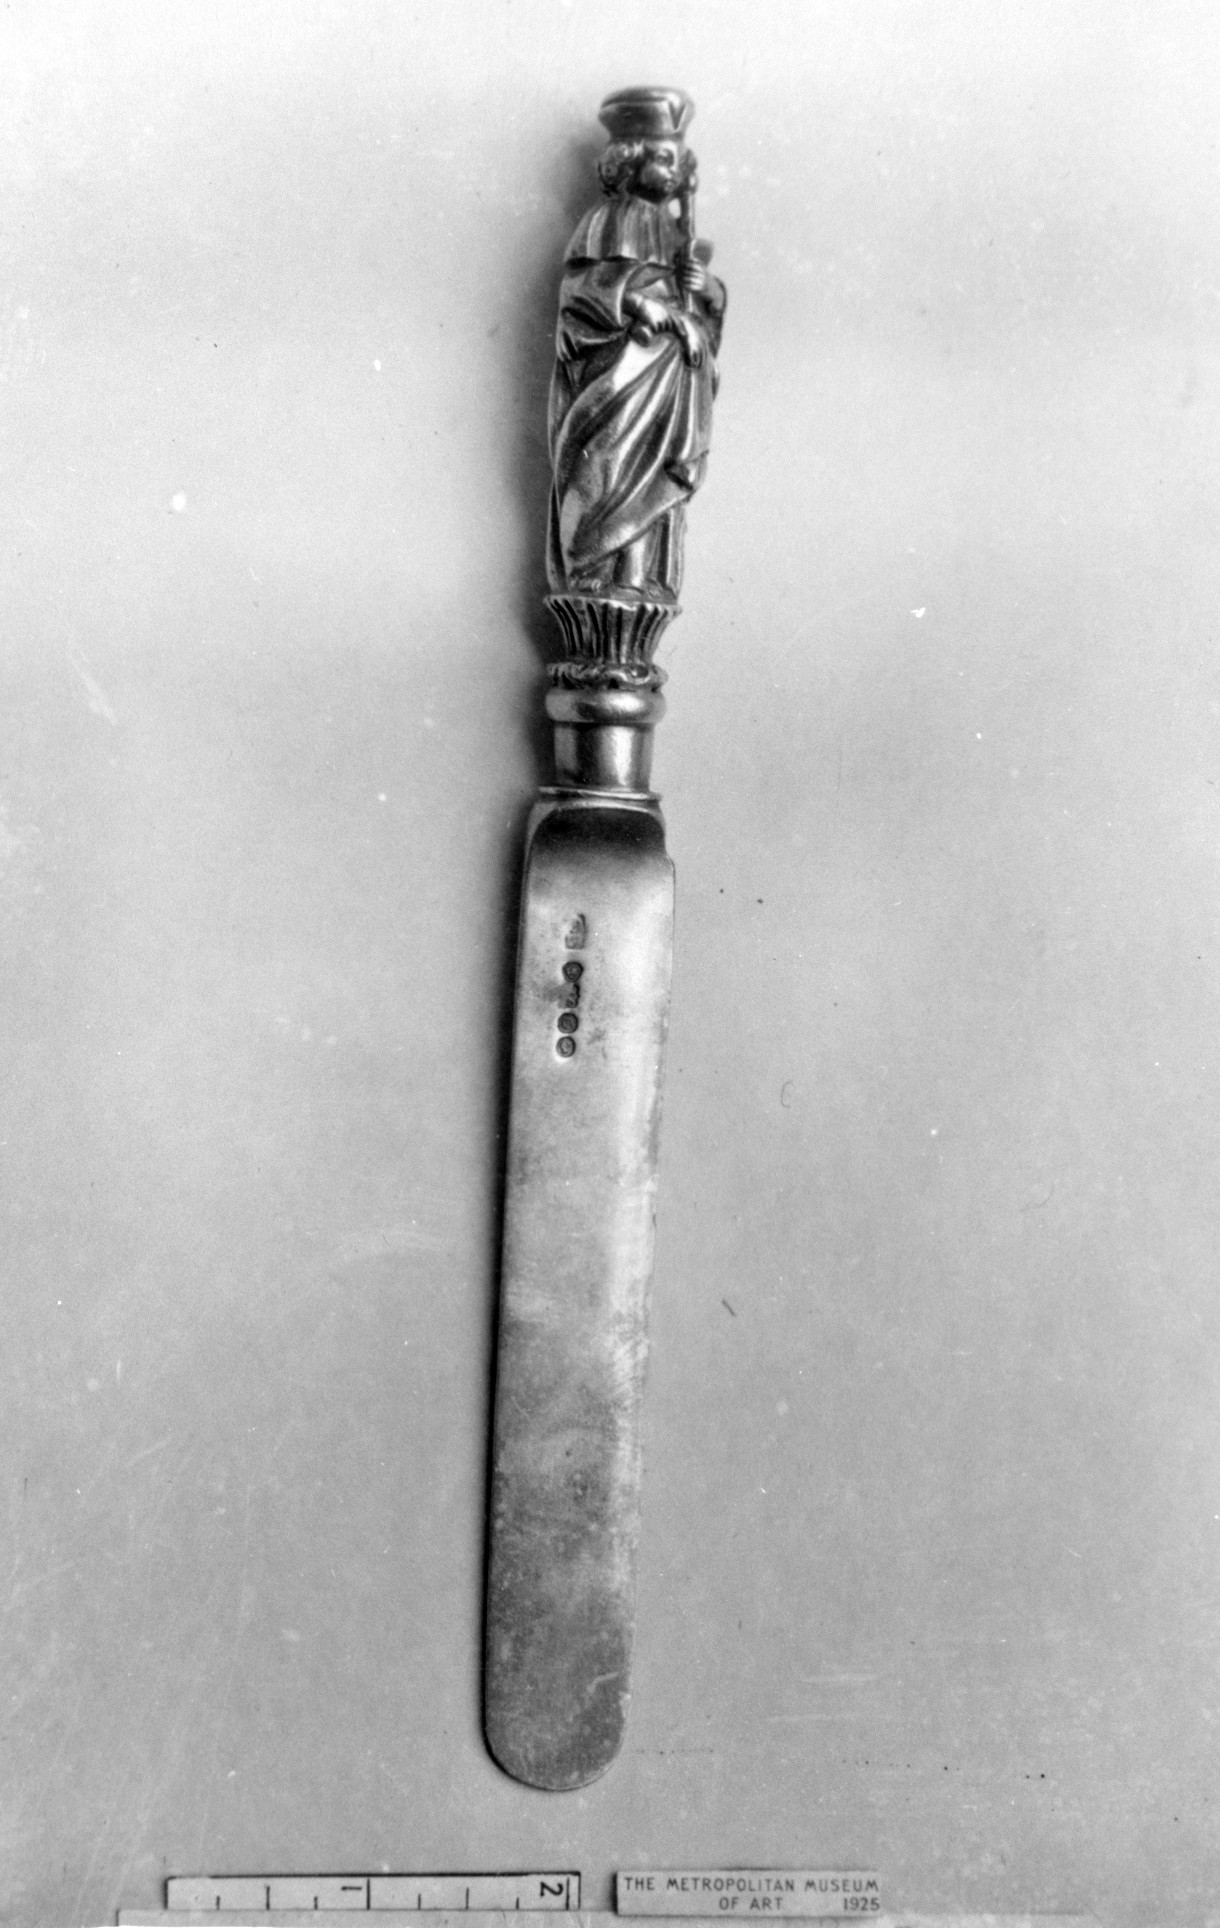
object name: knife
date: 1839-1840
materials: silver gilt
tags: men